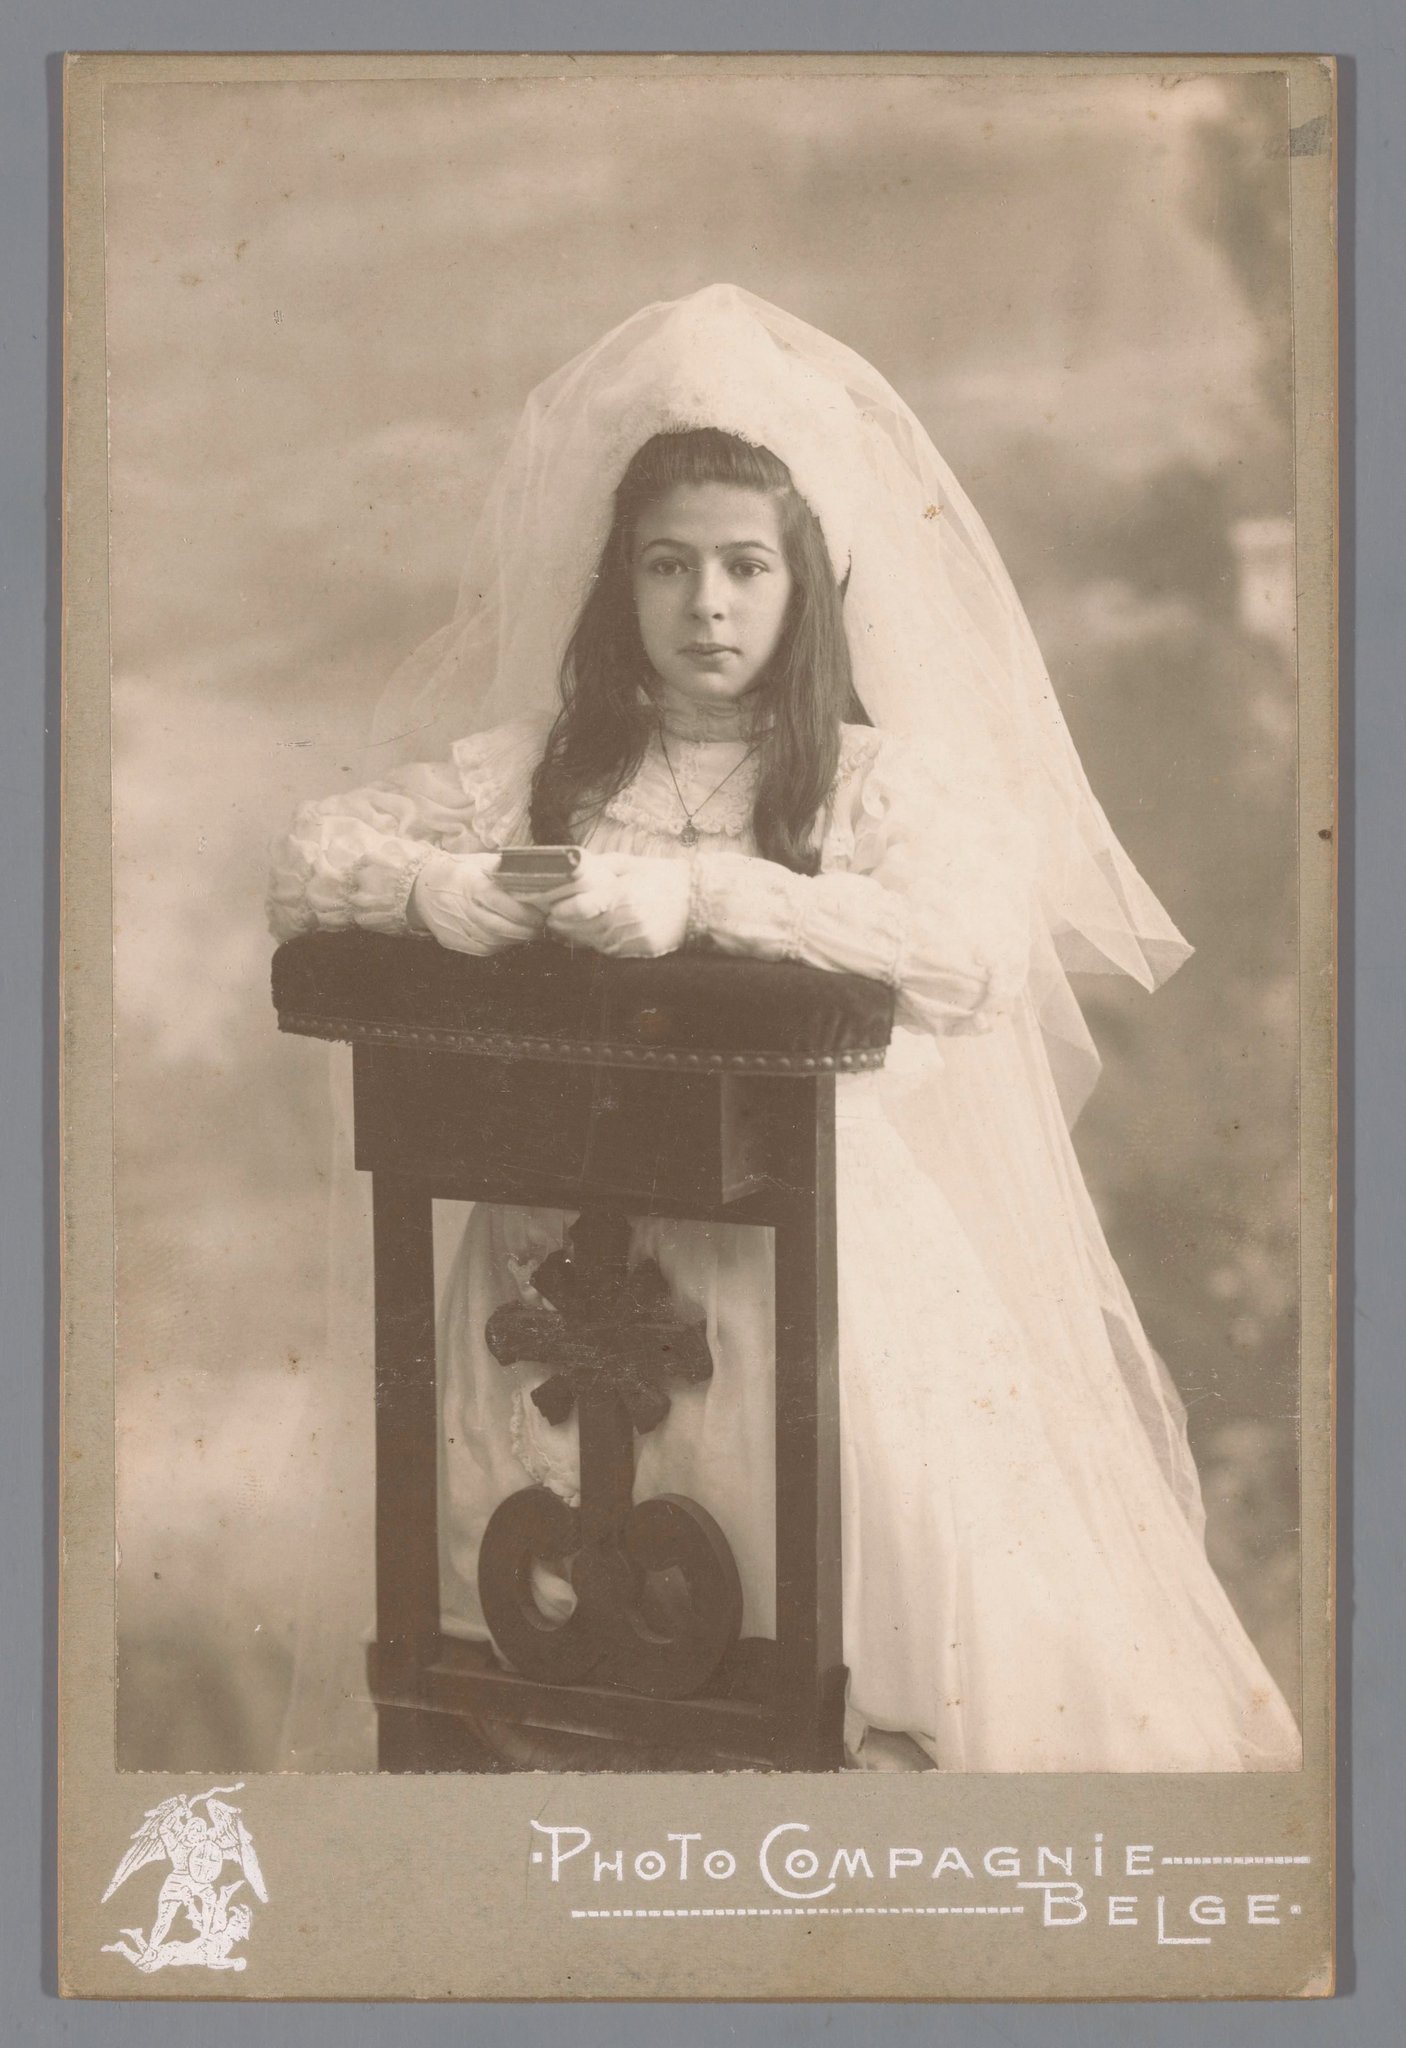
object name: cabinet photograph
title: Portret van een onbekende communicant achter een bidstoel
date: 1880-1910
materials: cardboard, photographic support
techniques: collodion silver print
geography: brussels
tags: studio requisites ~ photographer, first communicant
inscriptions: name: ‘Photo Compagnie Belge Maison principale Bruxelles 109, Rue Neuve (...)’